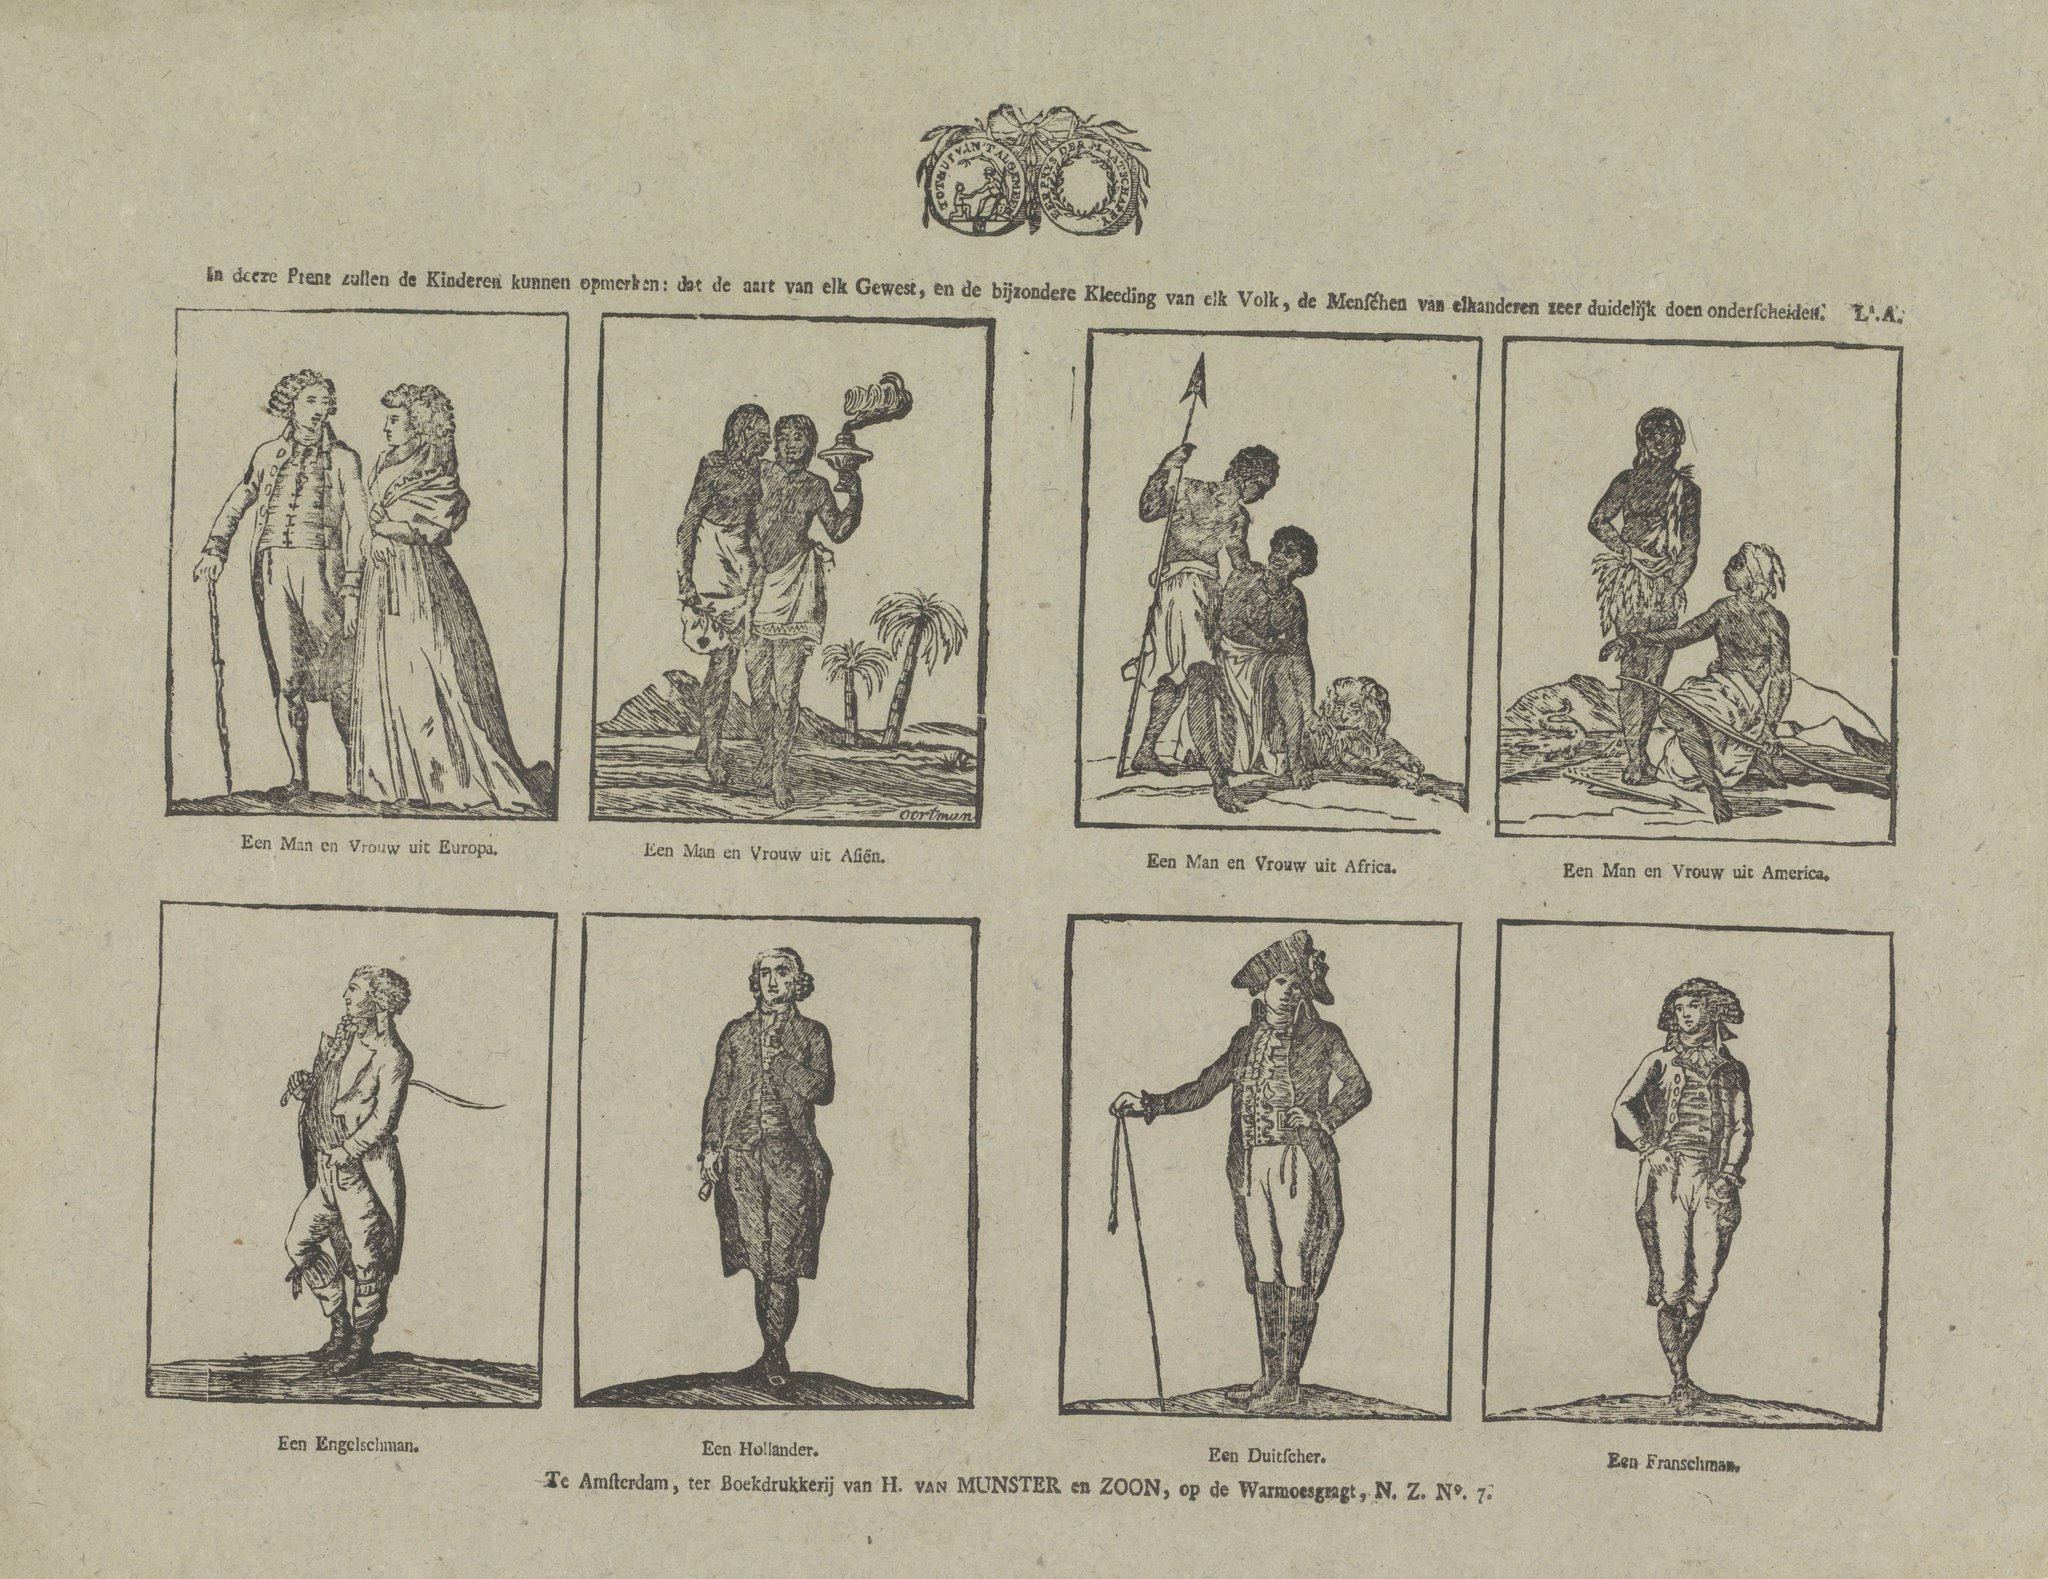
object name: print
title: In deeze prent zullen de kinderen kunnen opmerken: dat de aart van elk gewest, en de bijzondere kleeding van elk volk, de menschen van elkanderen zeer duidelijk doen onderscheiden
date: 1811-1829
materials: paper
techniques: letterpress printing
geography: amsterdam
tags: folk costume, regional costume, clothes, costume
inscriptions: collector's mark: Lugt 2760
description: Blad met 8 voorstellingen van de kleding van verschillende nationaliteiten en volkeren. Midden boven het zegel van de Maatschappij tot Nut van 't Algemeen. Onder elke afbeelding een onderschrift. Genummerd rechtsboven: L.A.